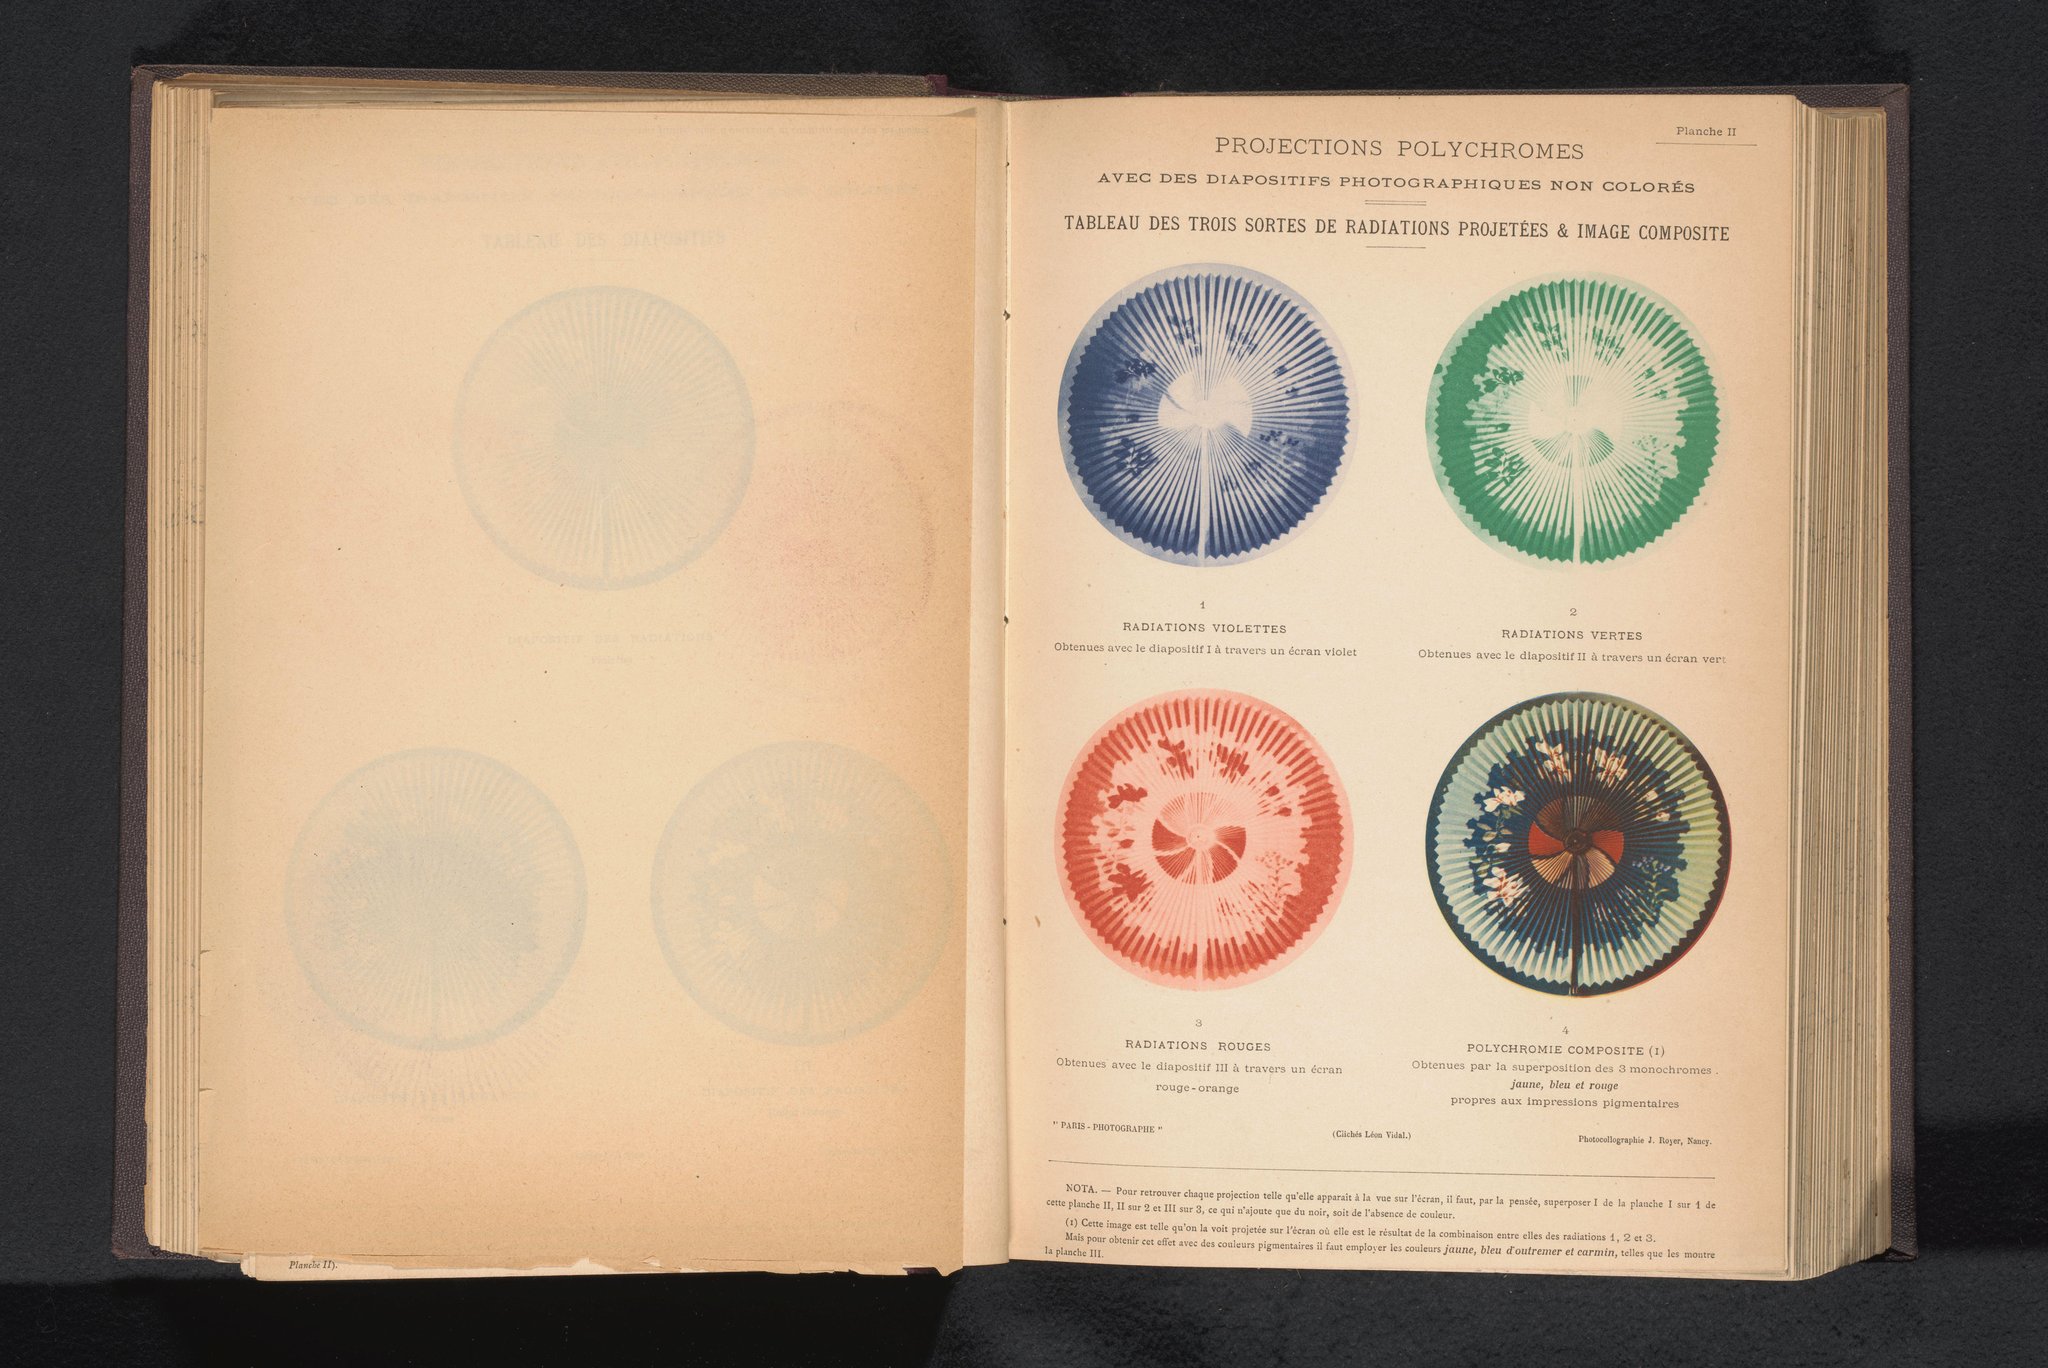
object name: page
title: Tableau des trois sortes de radiations projetées & image composite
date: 1882-1892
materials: paper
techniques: photograph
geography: nancy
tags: lantern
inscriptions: number: ‘Planche II’, inscription: ‘Projections polychromes avec des diapositifs photographiques non colorés (...)’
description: Drie opnamen zijn ieder met een ander kleurenfilter genomen, de vierde is een samenvoeging van de drie afzonderlijke kleuren.